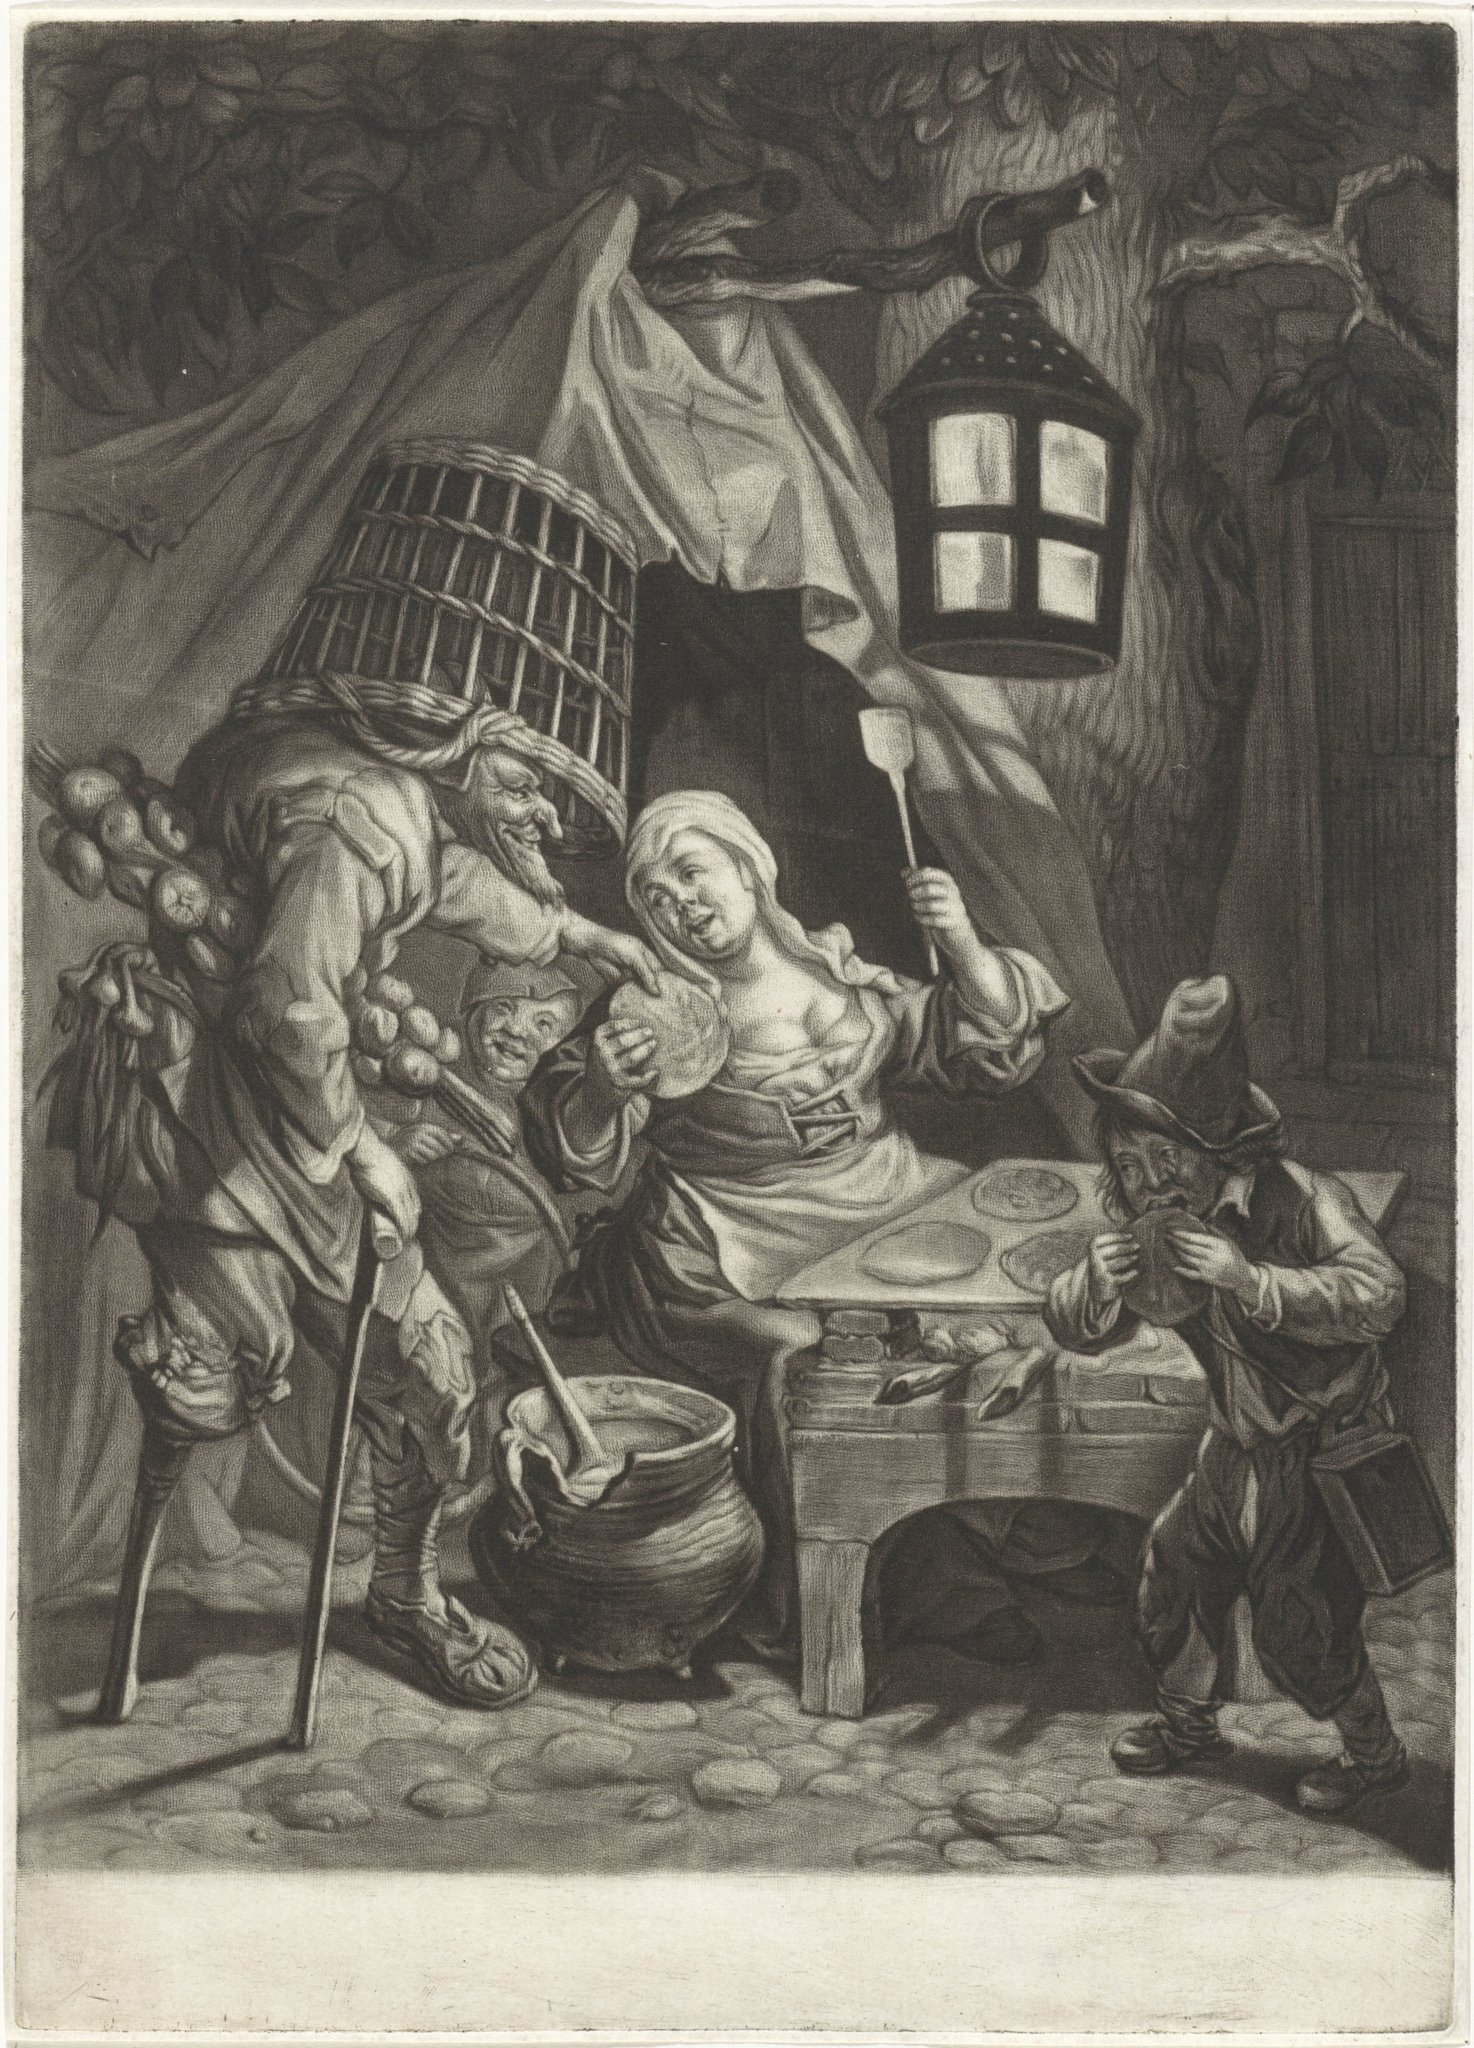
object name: print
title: De vijf zintuigen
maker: jacob gole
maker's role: print maker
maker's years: 1660-1724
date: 1670-1724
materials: paper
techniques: mezzotint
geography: haarlem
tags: taste, tasting (one of the five senses), baker, waffles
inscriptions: collector's mark: Lugt 240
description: Een pannenkoekenbakster zit voor haar tent en probeert een landloper, die een pannenkoek heeft gestolen, op zijn handen te slaan. Op de voorgrond een jongen die een pannenkoek eet. De prent maakt deel uit van een serie van vijf prenten met de vijf zintuigen.